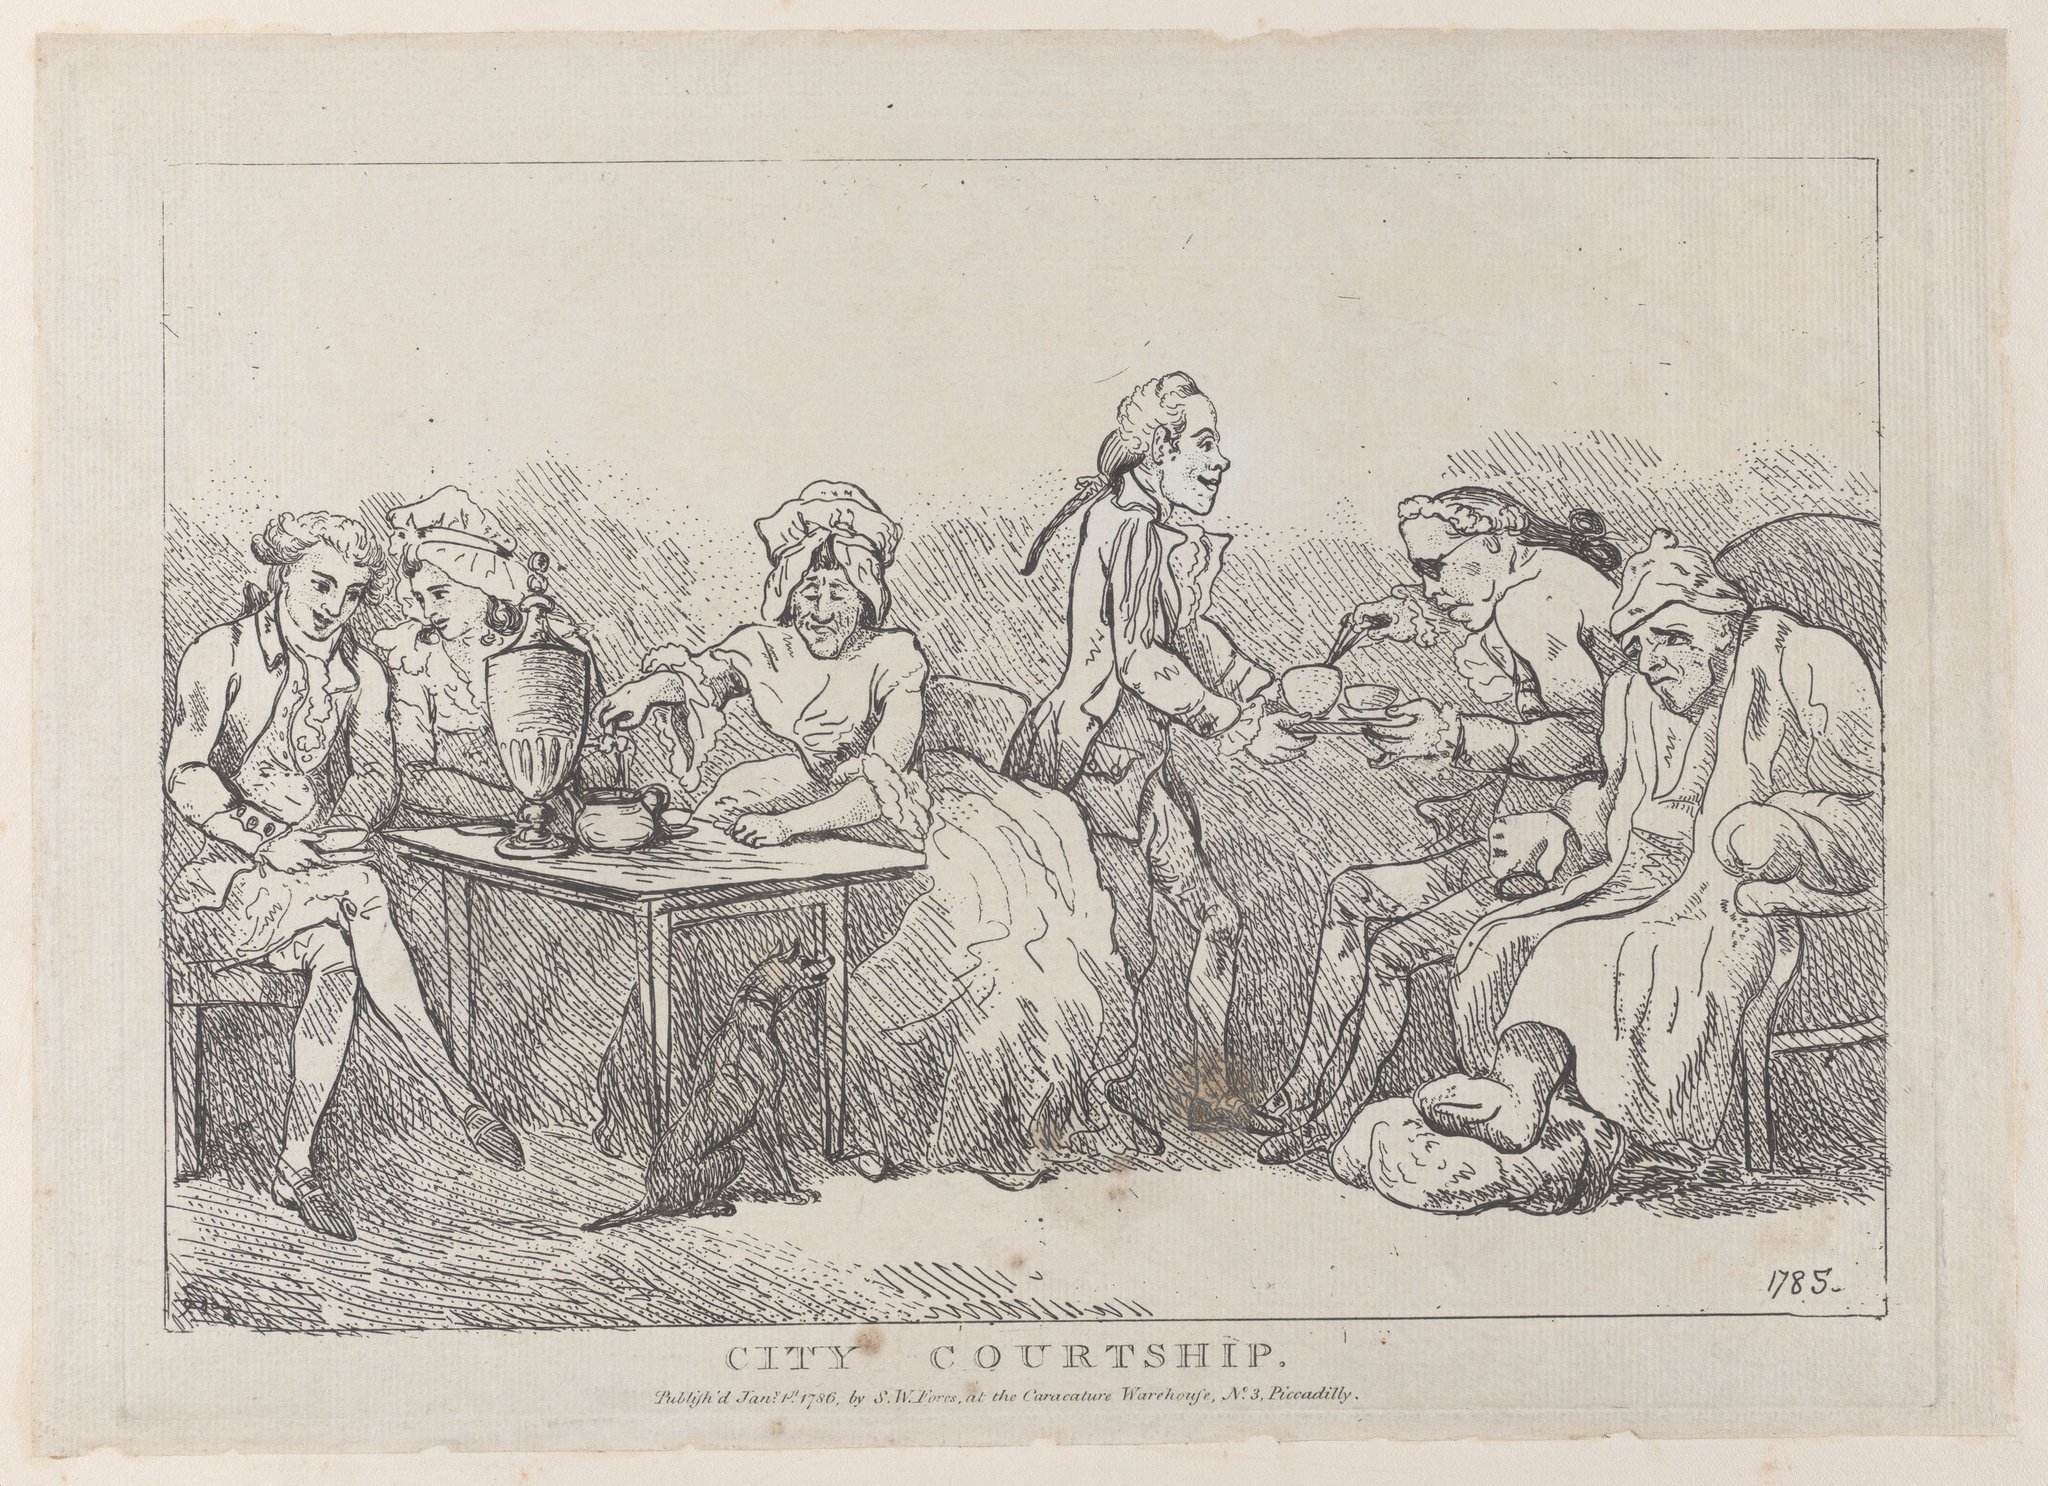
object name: print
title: City Courtship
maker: thomas rowlandson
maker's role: artist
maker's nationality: british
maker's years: 1757-1827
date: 1786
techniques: etching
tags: satire,men,women,tea drinking